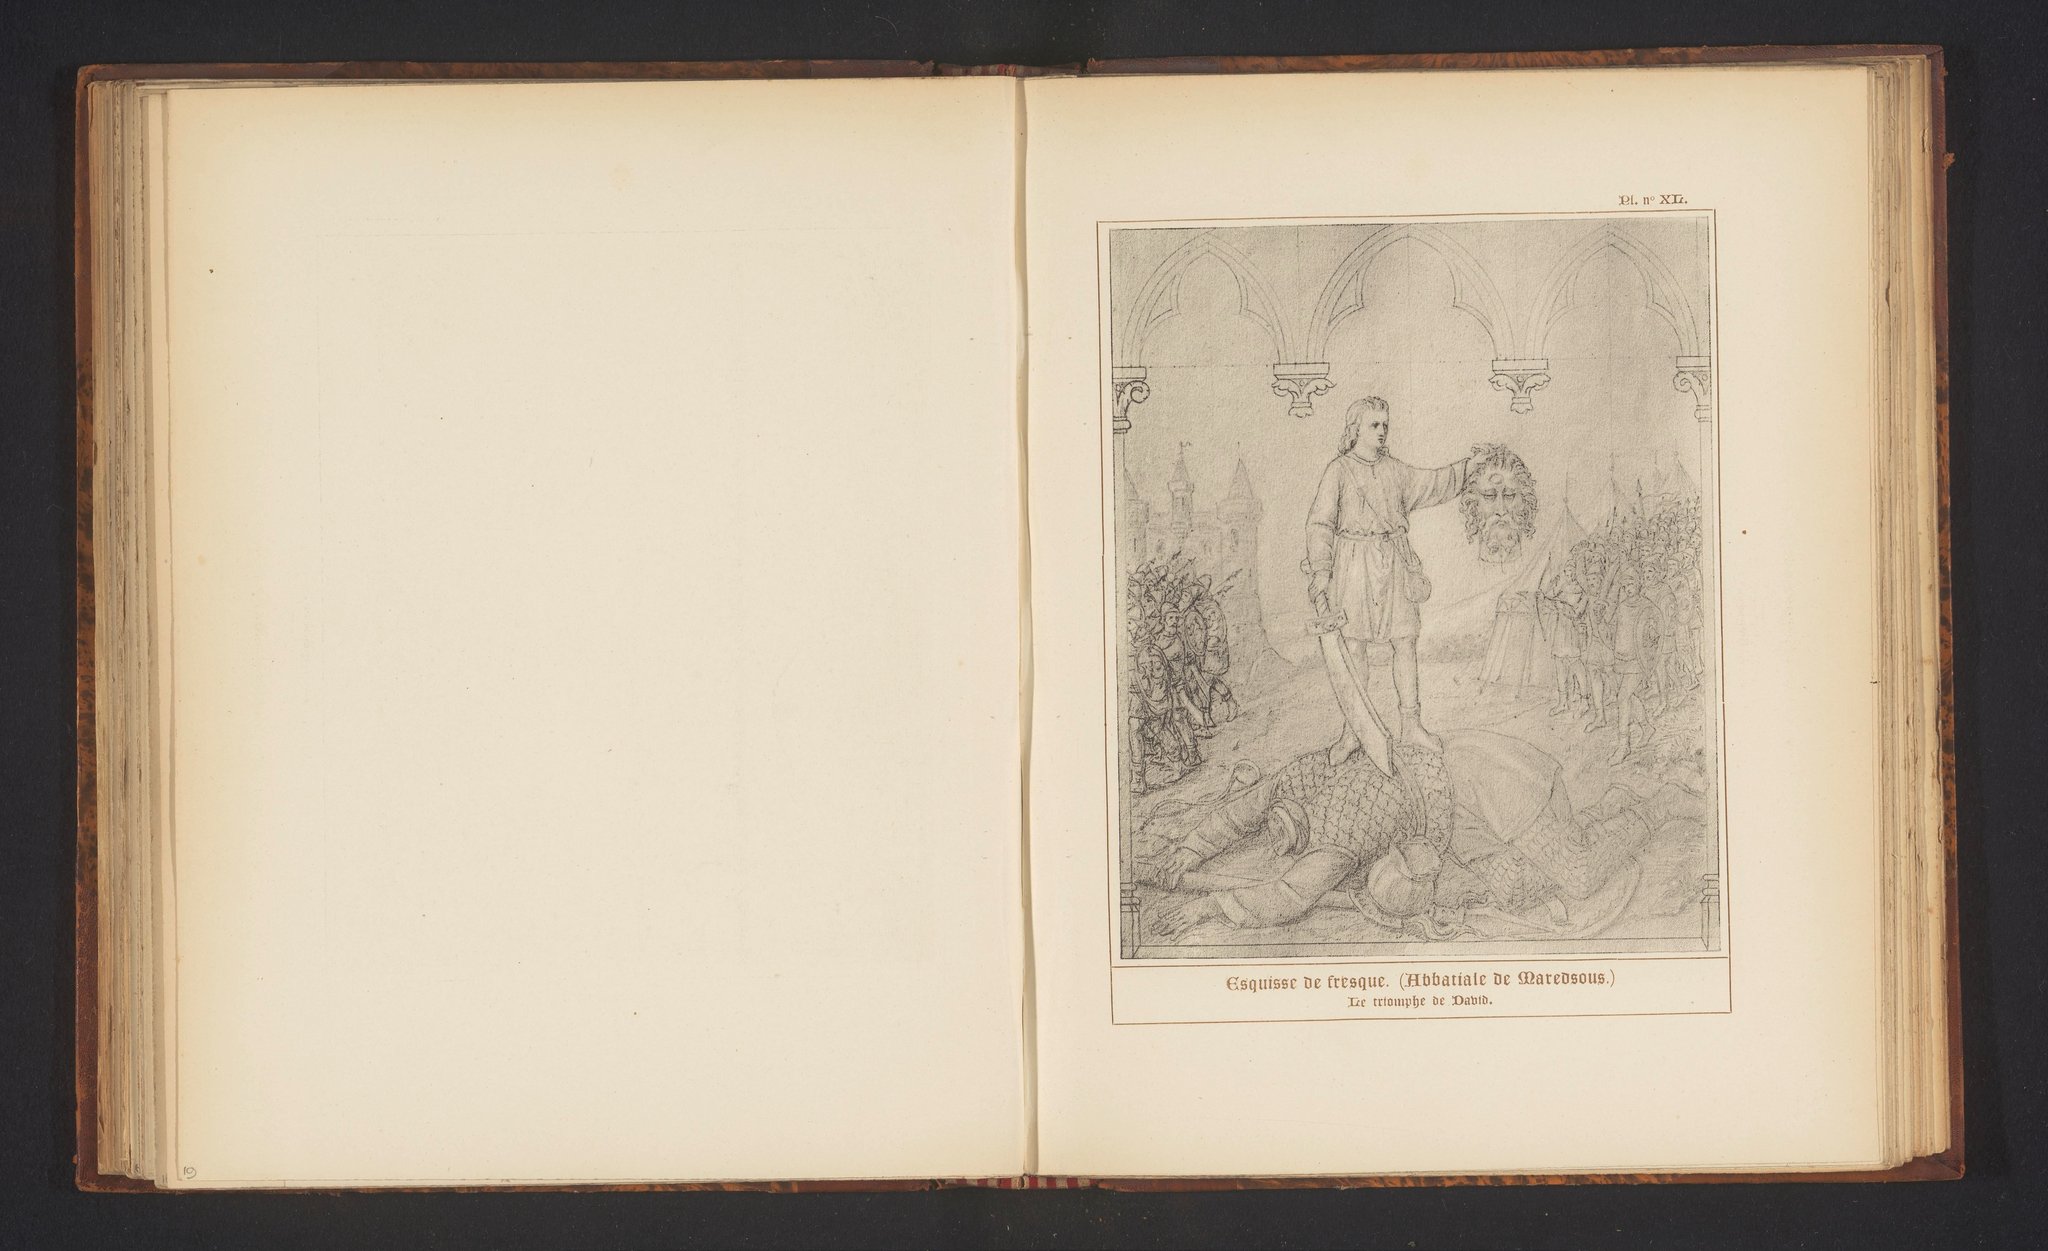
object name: reproduction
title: Esquisse de fresque. (Abbatiale de Maredsous)/ Le triomphe de David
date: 1891-1896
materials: paper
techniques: photograph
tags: david's triumph: the women of israel come out to welcome david, singing, dancing, and playing tambourines and lyres; david holding the head of goliath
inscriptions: number: ‘Pl. no XL.’